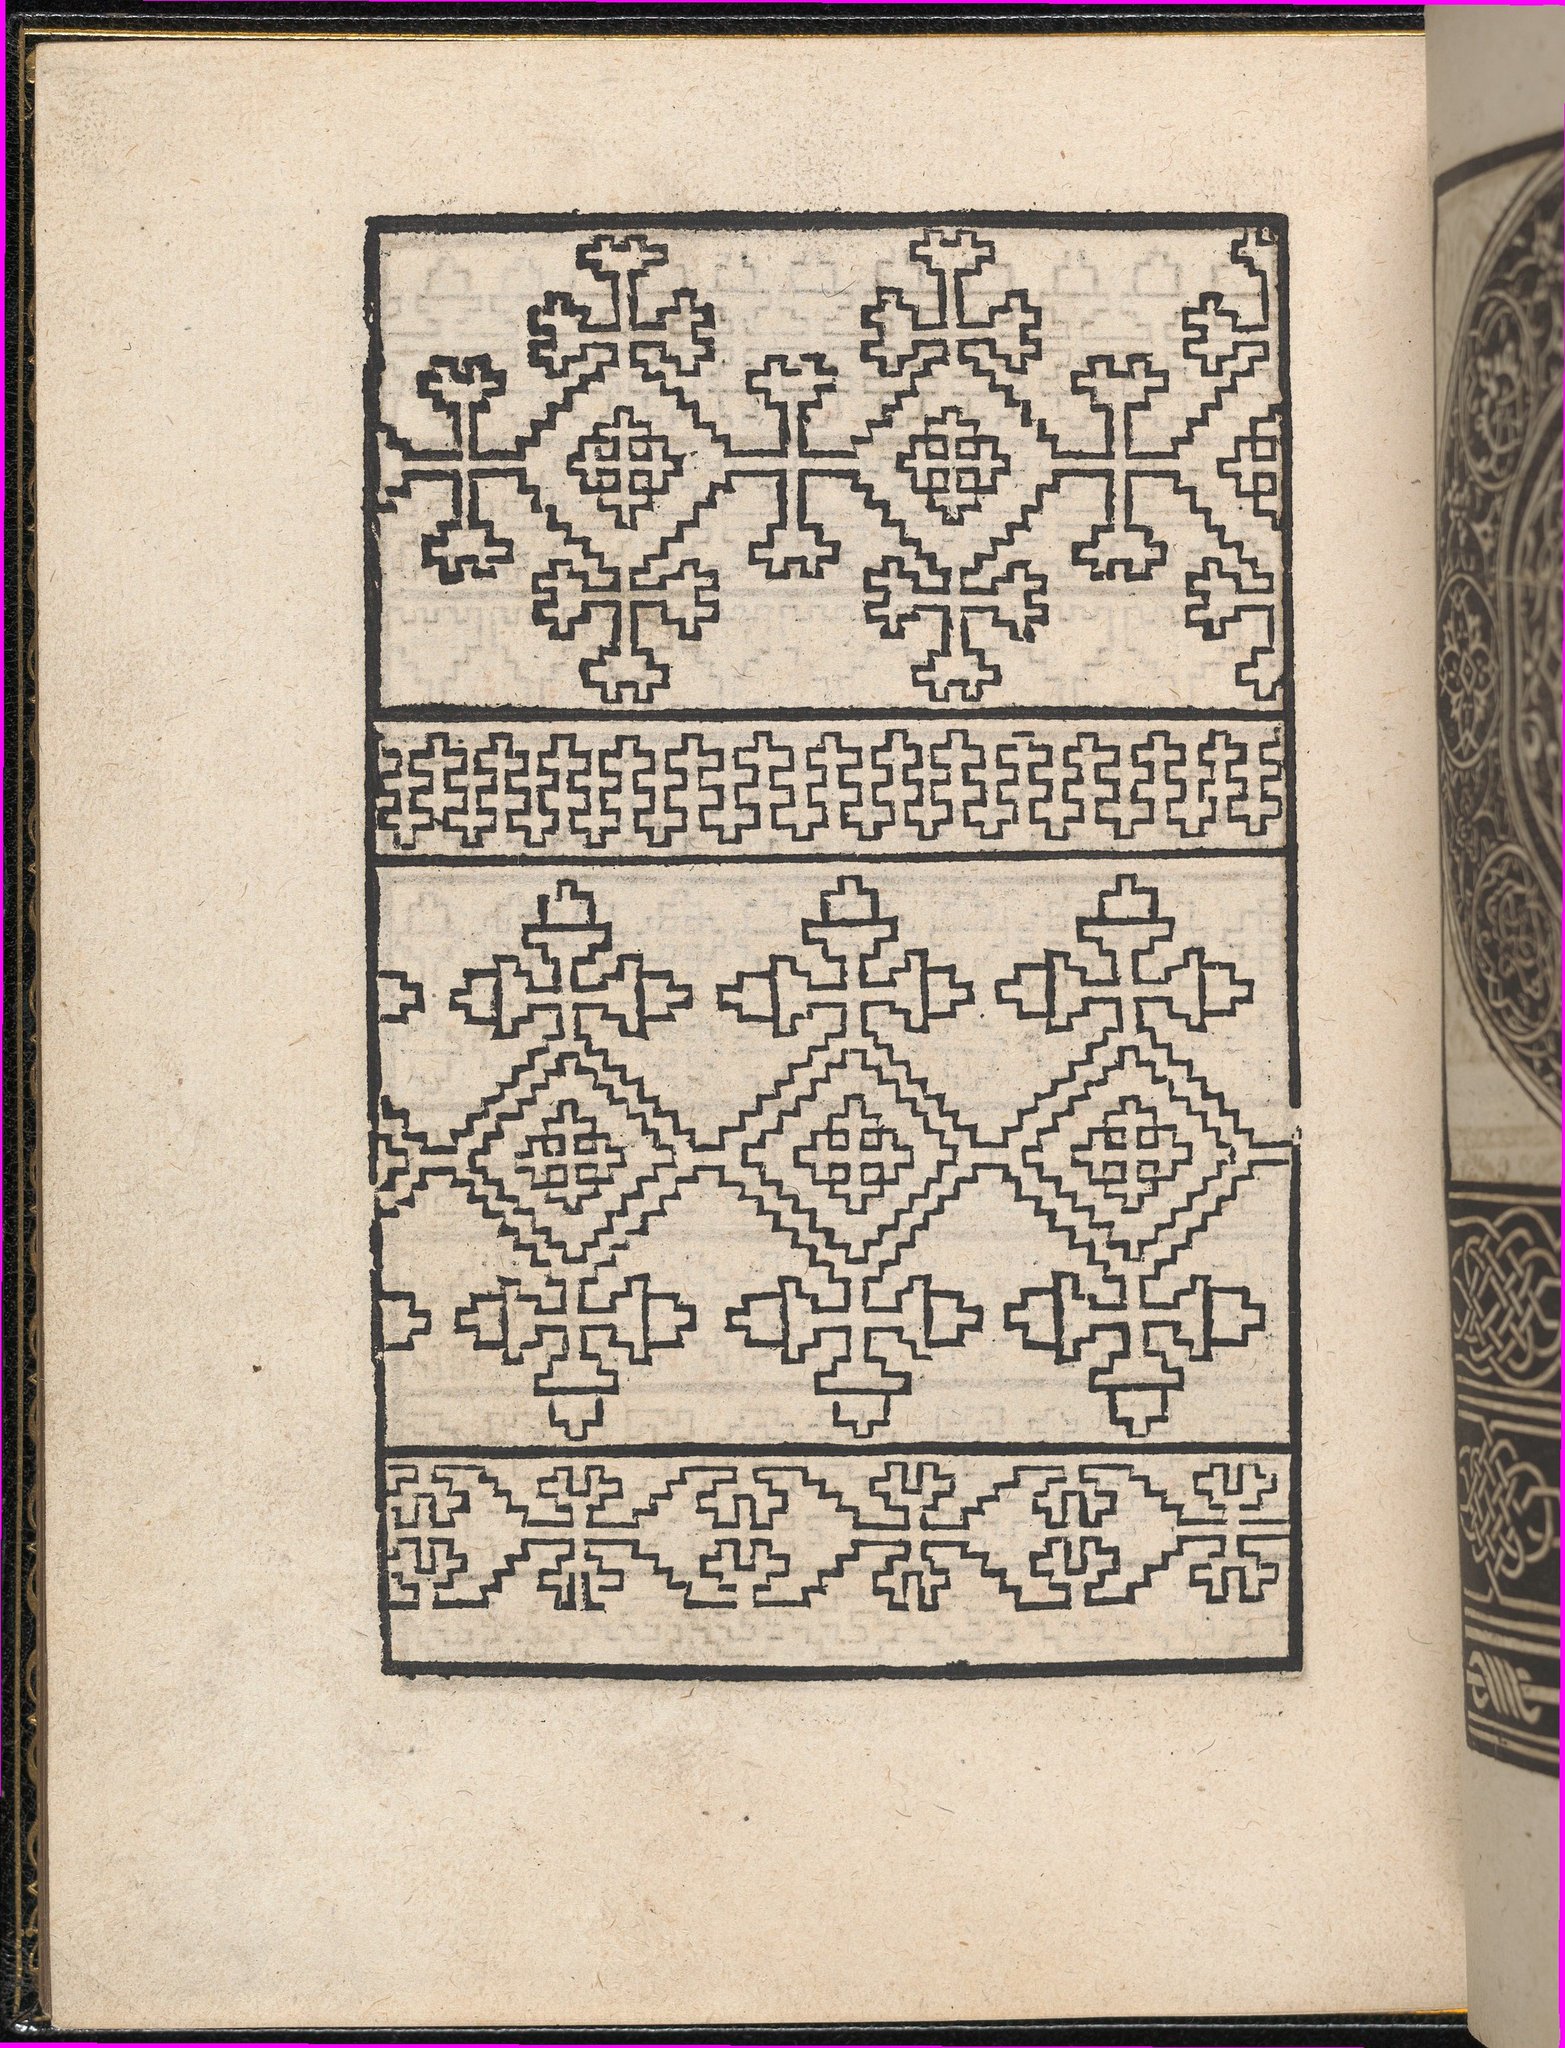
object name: book print ornament architecture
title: Page from Ein new kunstlich Modelbuch...(Page 47v)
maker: peter quentel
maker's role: publisher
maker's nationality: german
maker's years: 1500-1550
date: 1544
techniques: woodcut